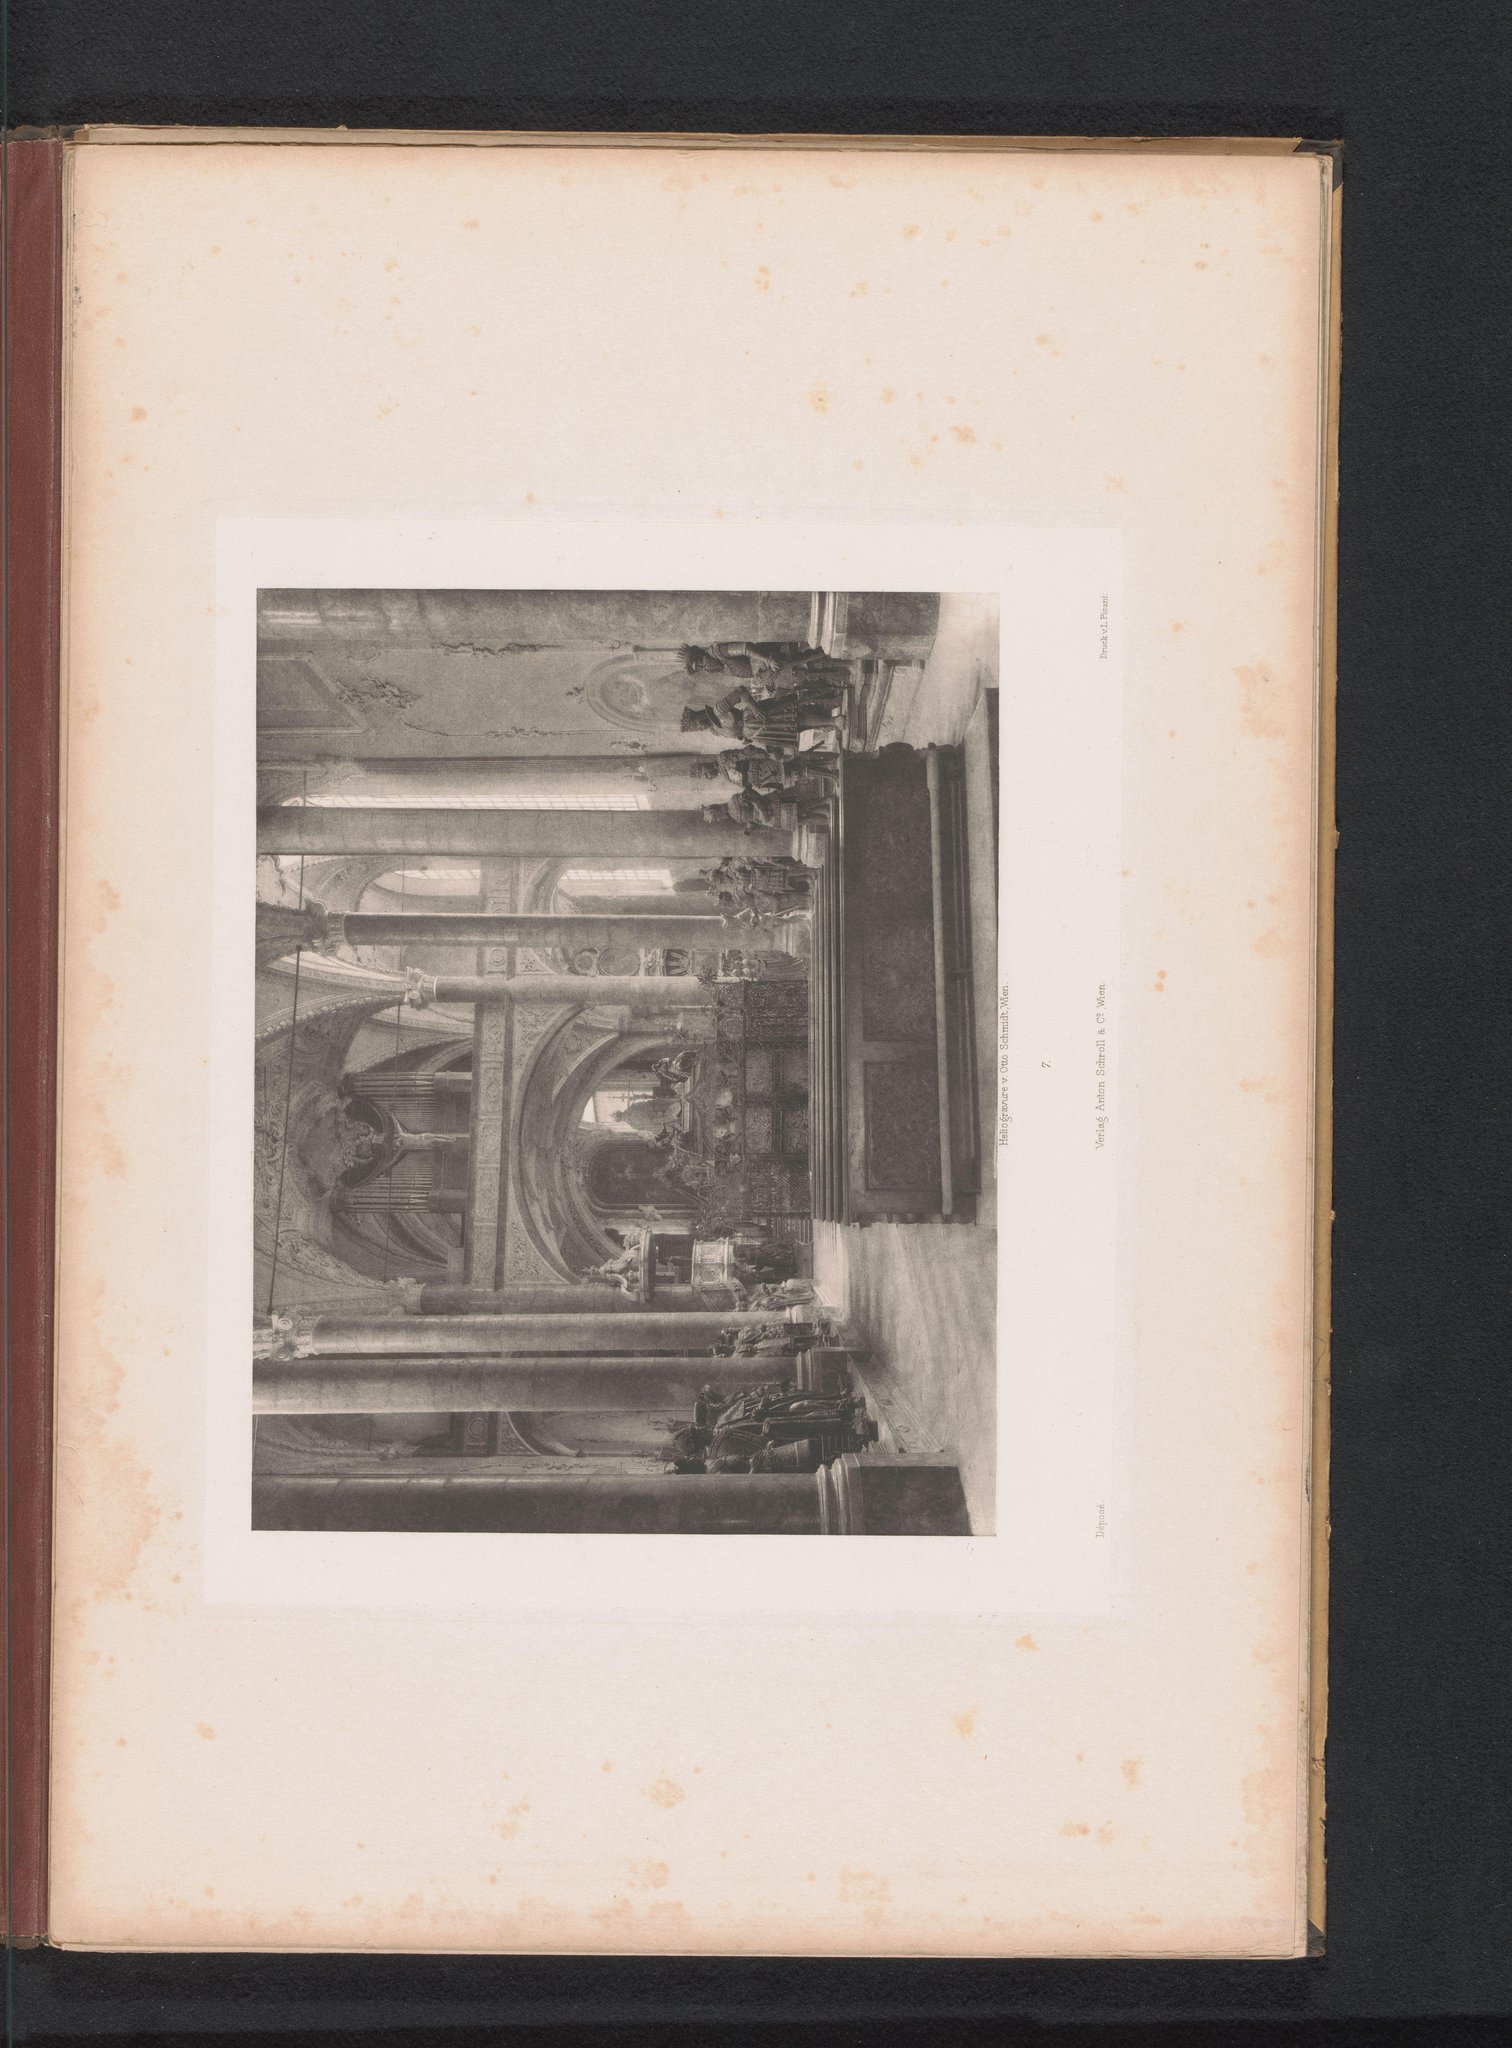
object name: photomechanical print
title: Bronzen standbeelden in de Hofkerk in Innsbruck, Oostenrijk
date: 1888-1893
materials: paper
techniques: photoaquatint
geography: vienna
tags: interior of church, piece of sculpture, reproduction of a piece of sculpture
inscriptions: inscription: ‘Déposé.’, number: ‘7.’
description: Deze prent maakt deel uit van een omslag met twintig prenten, twee tekstbladen en een titelpagina.